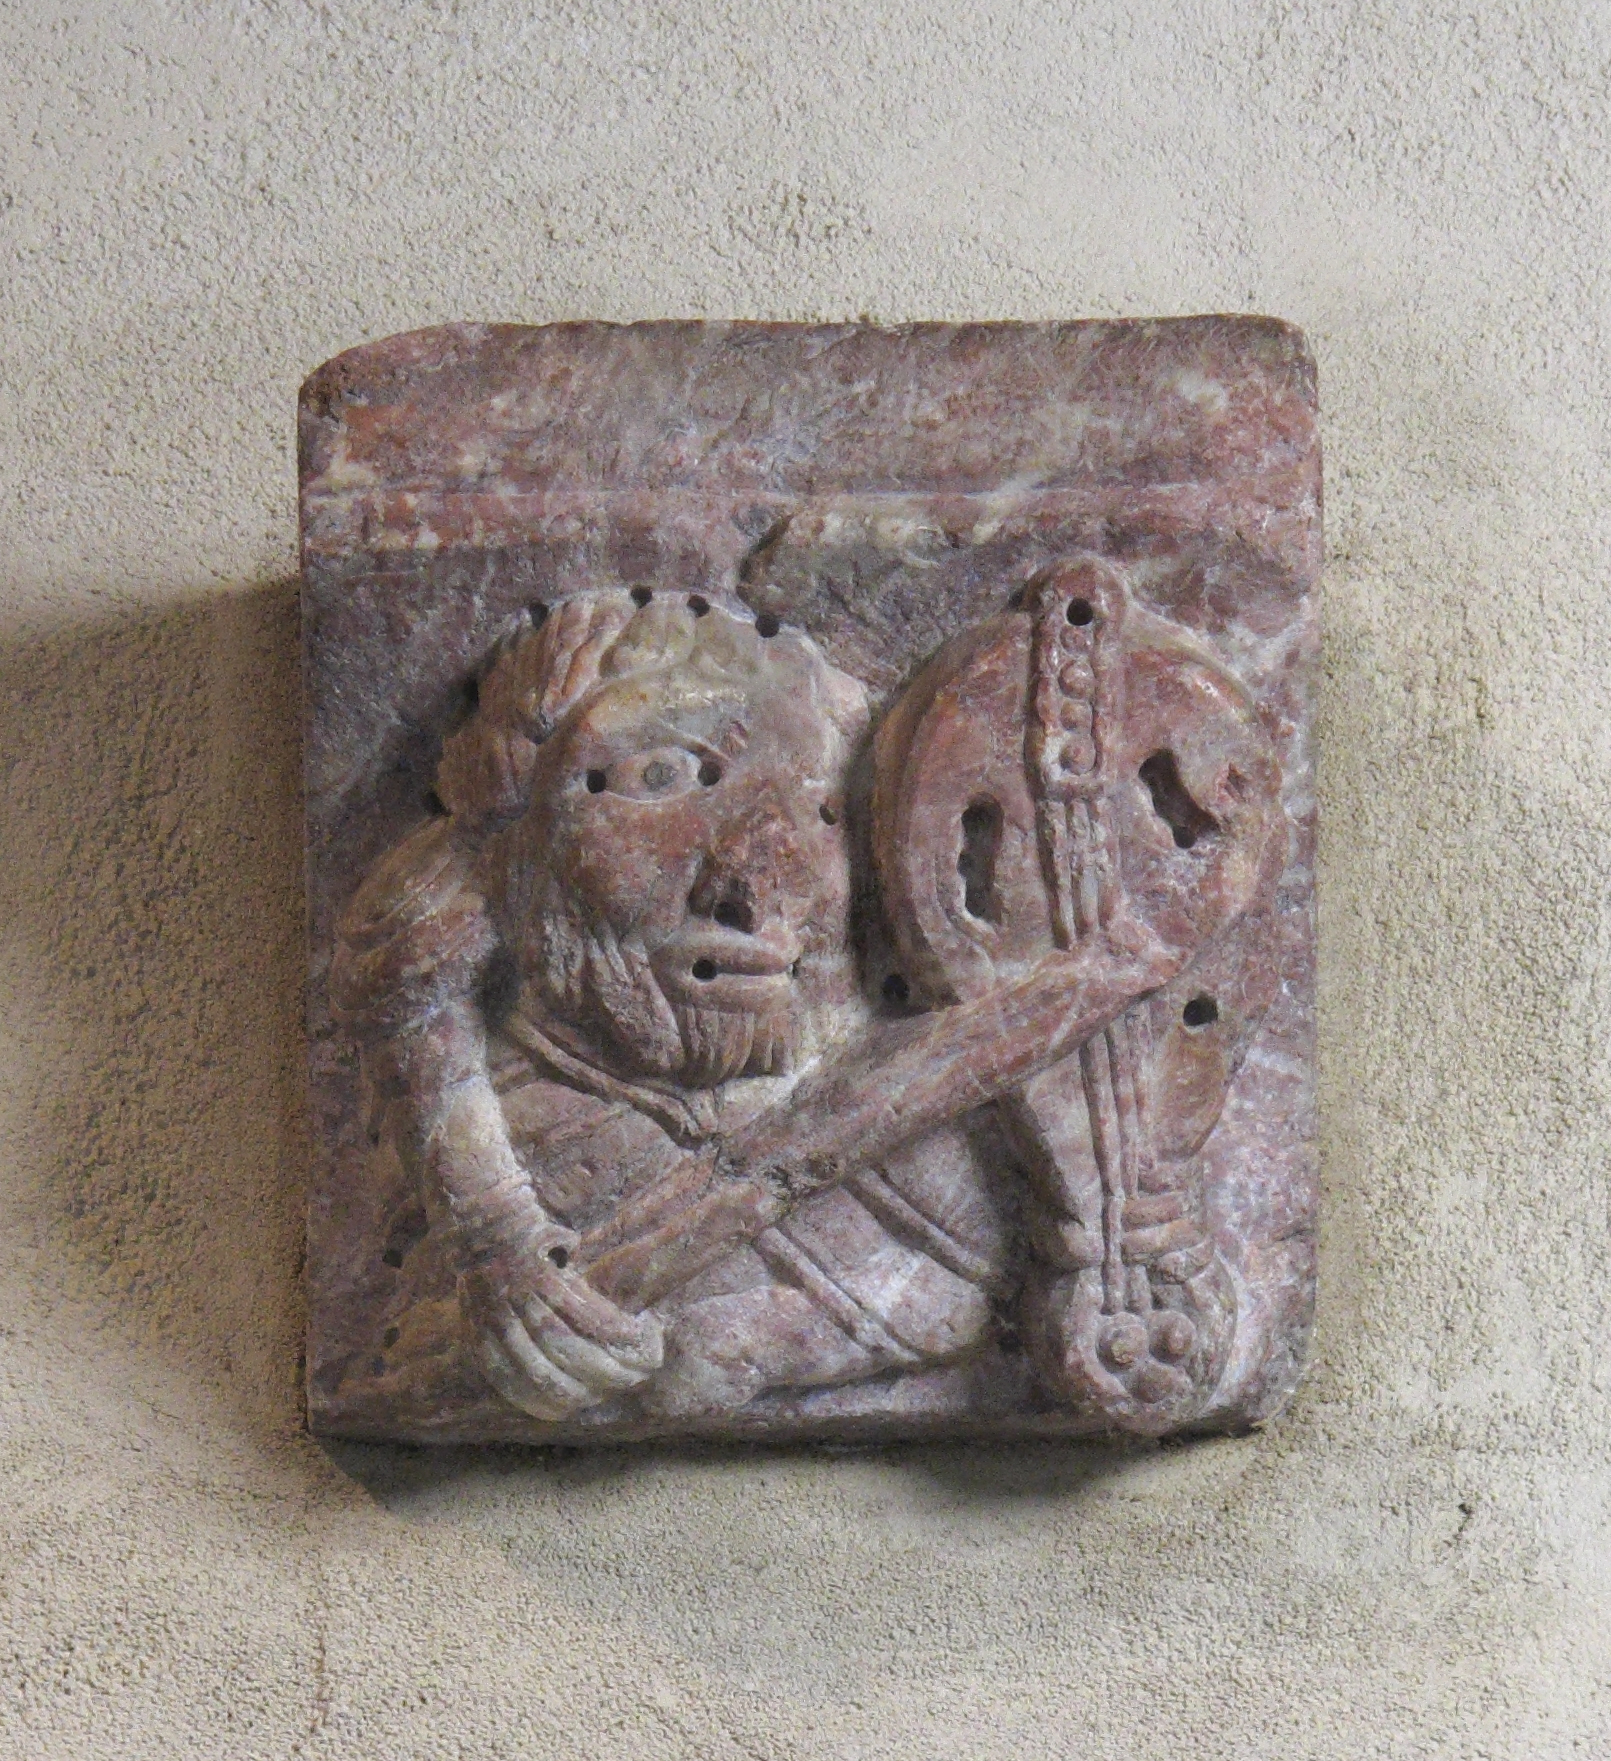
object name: corbel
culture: catalan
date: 1130-1140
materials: marble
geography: france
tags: musicians